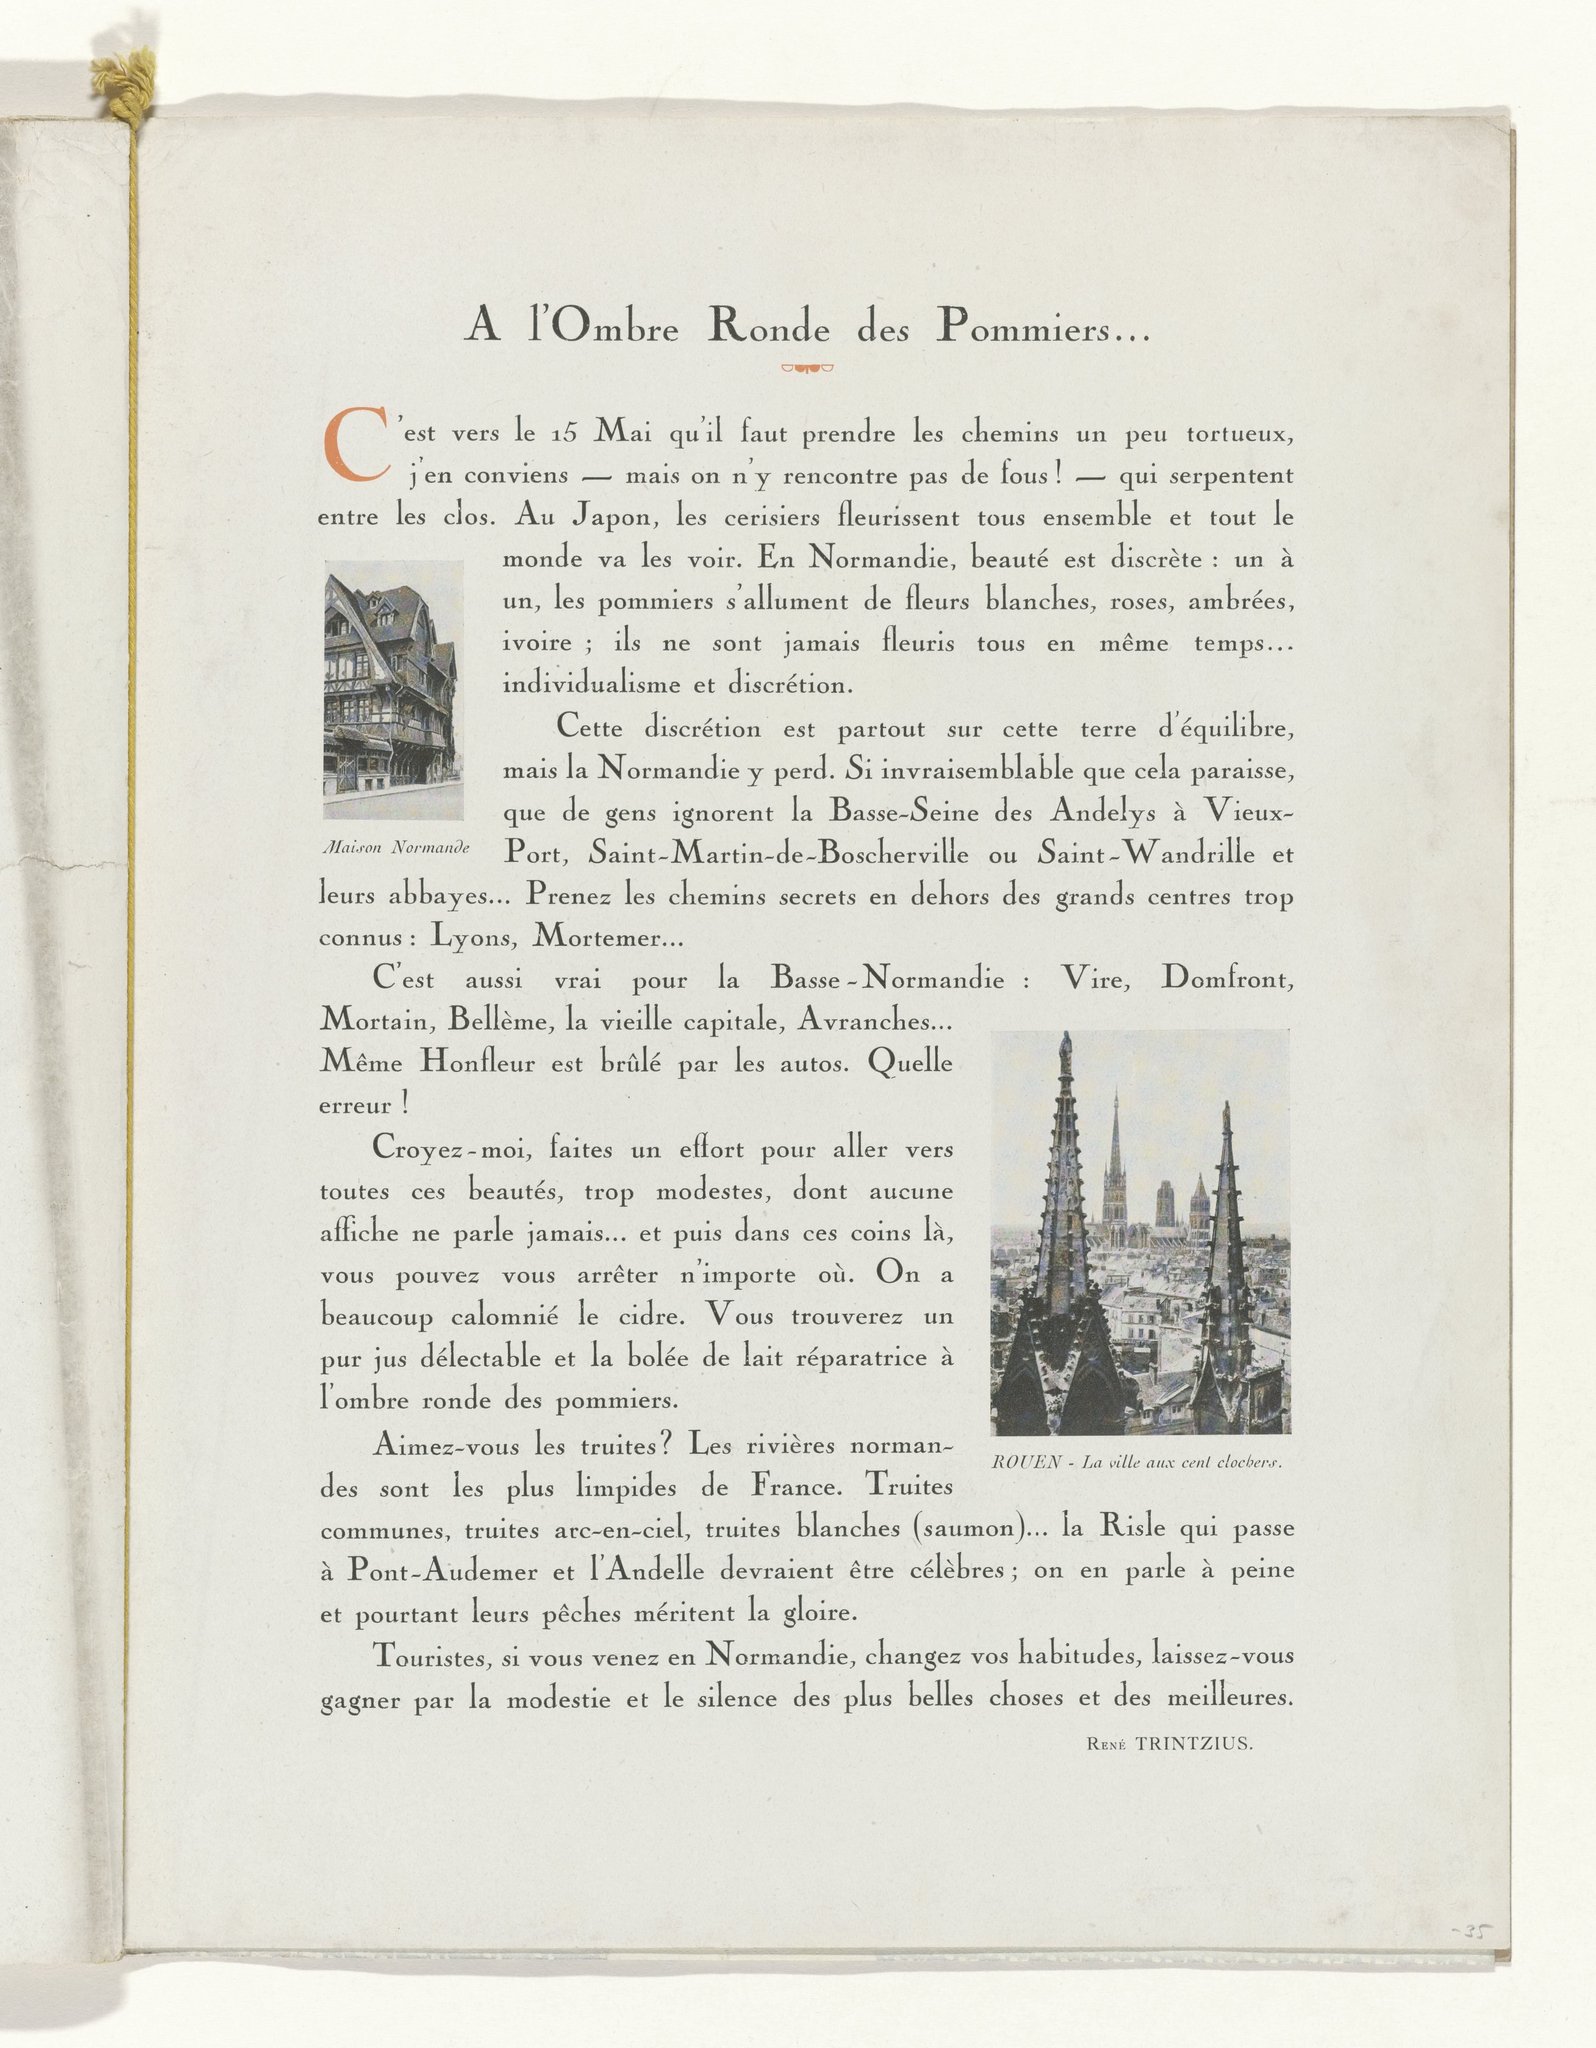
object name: magazine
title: Art - Goût - Beauté, Feuillets de l' élégance féminine, Mai 1931, No. 129, 11e Année, p. 35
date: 1931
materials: paper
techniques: printing, photography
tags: fashion plates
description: Tekst 'A l'Obre Ronde des Ponniers...' met twee afbeeldingen van 'Maison Normande' en 'Rouen - La ville aux cent clochers.'. Pagina uit het modetijdschrift Art-Goût-Beauté (1920-1933).